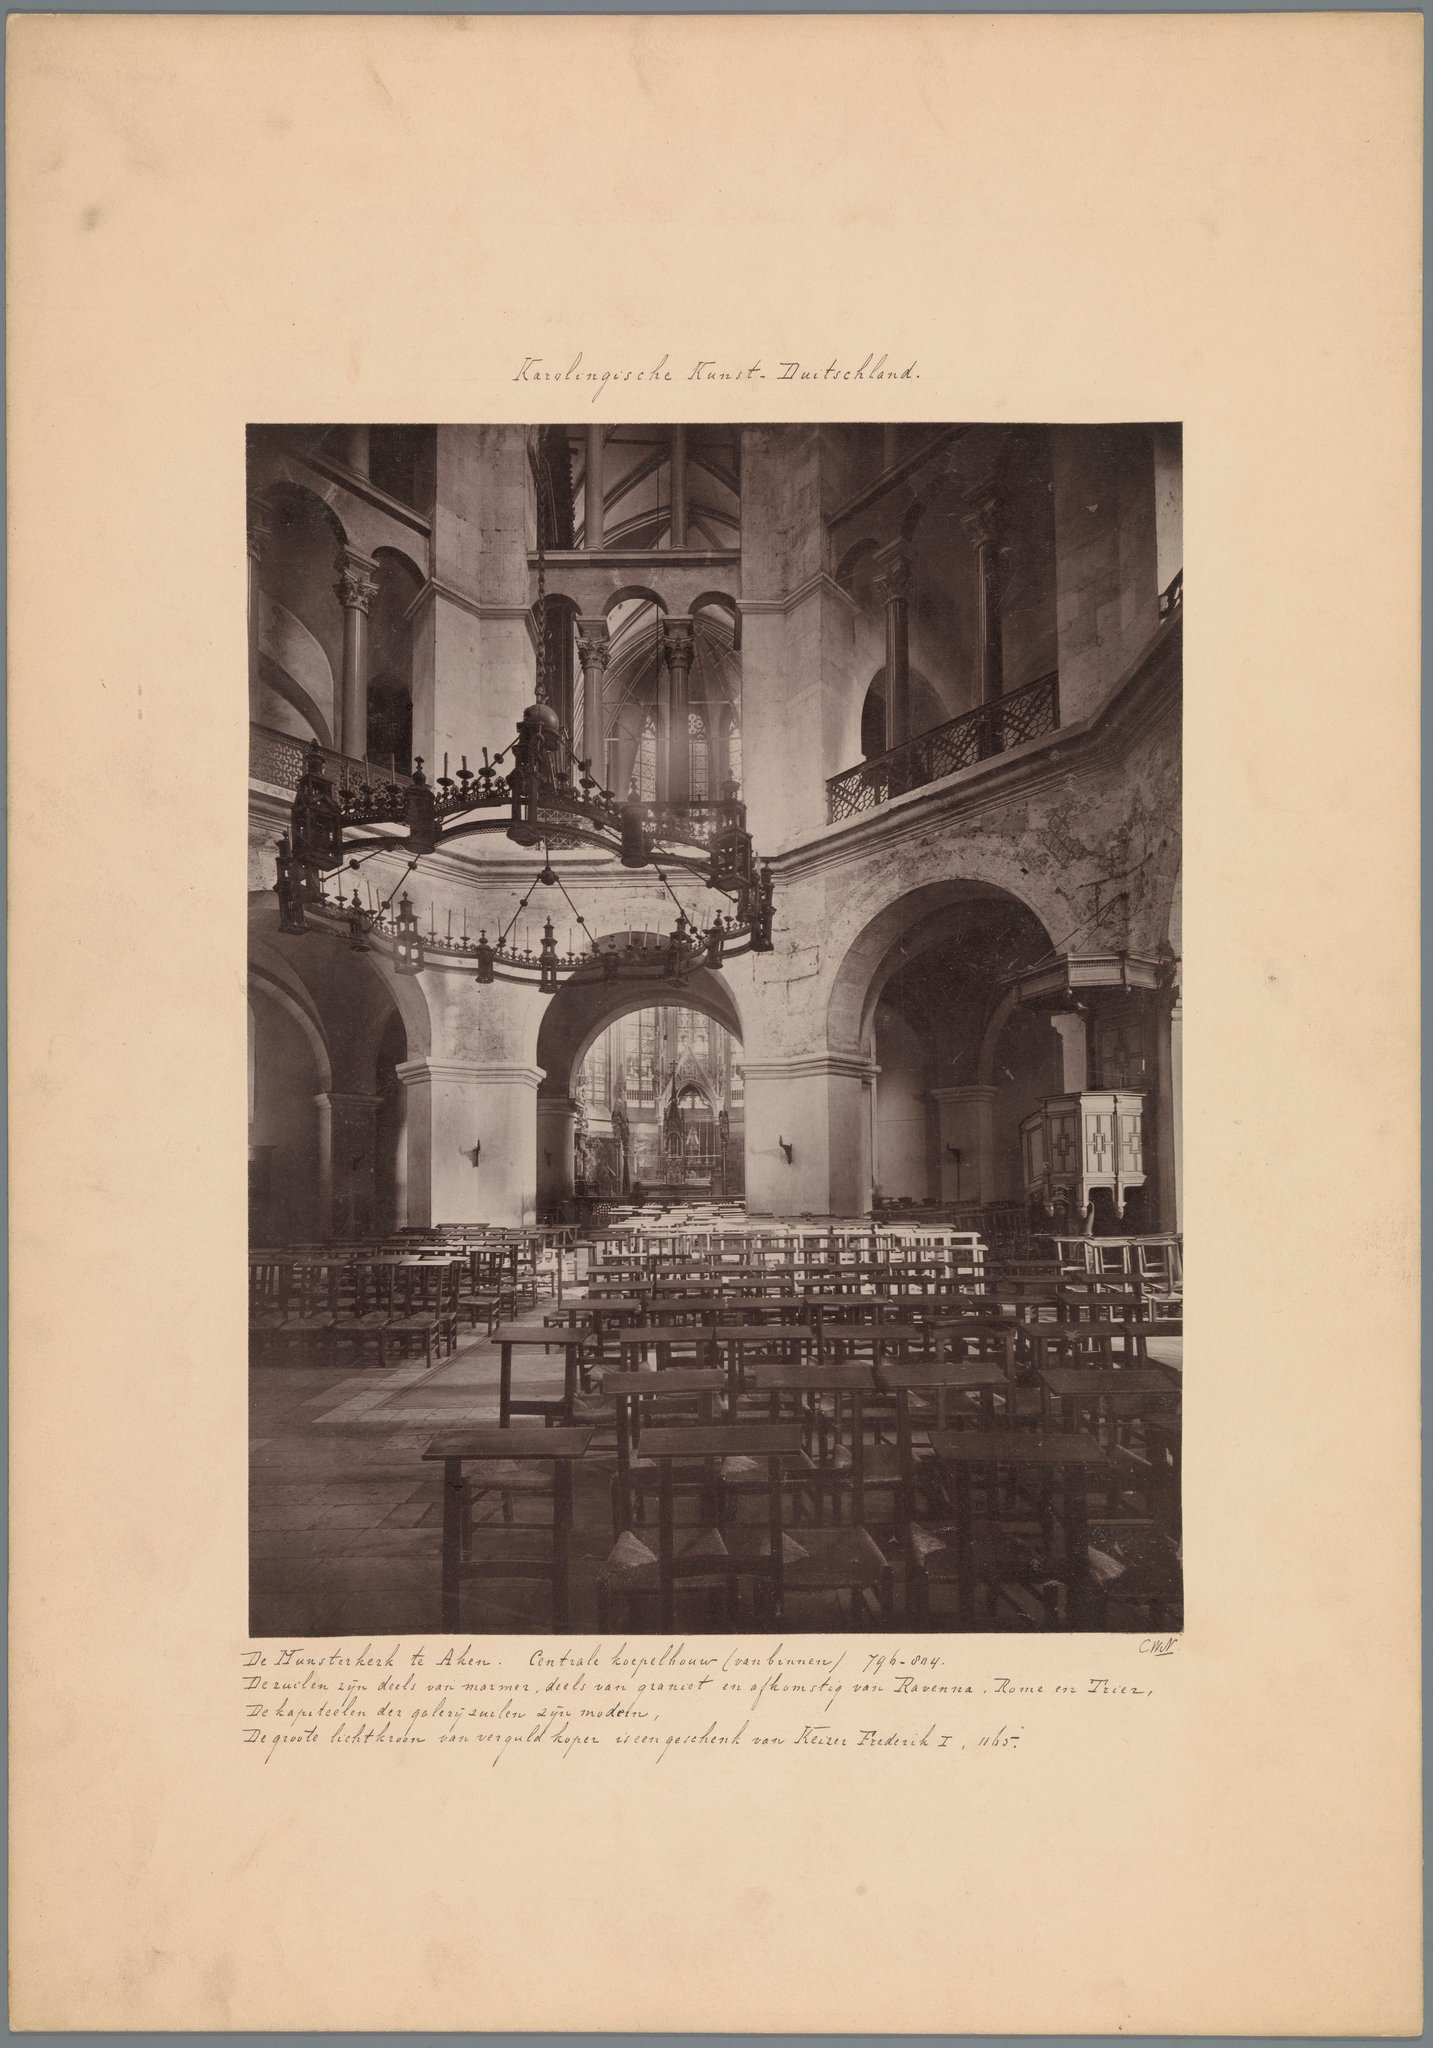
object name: photograph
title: Interieur van de Paltskapel te Aken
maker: Anonymous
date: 1875-1900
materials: cardboard, paper, ink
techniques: photograph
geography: palatine chapel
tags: column, pillar ~ architecture, chandelier, candelabrum, parts of church interior: chapel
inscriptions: collector's mark: ‘INSTITUUT VOOR KUNST- NIJVERHEIDSONDERWIJS GABRIËL METSUSTRAAT No. 16. AMSTERDAM’, inscription: ‘Karolingische Kunst - Duitschland. De Munsterkerk te Aken (...) De groote lichtkroon van verguld koper is een geschenk van Keizer Frederik I , 1165.’, inscription: ‘CWN.’, collector's mark: ‘KUNSTNIJVERHEIDSCHOOL QUELLINUS AMSTERDAM FRANS HALSSTRAAT 14.’